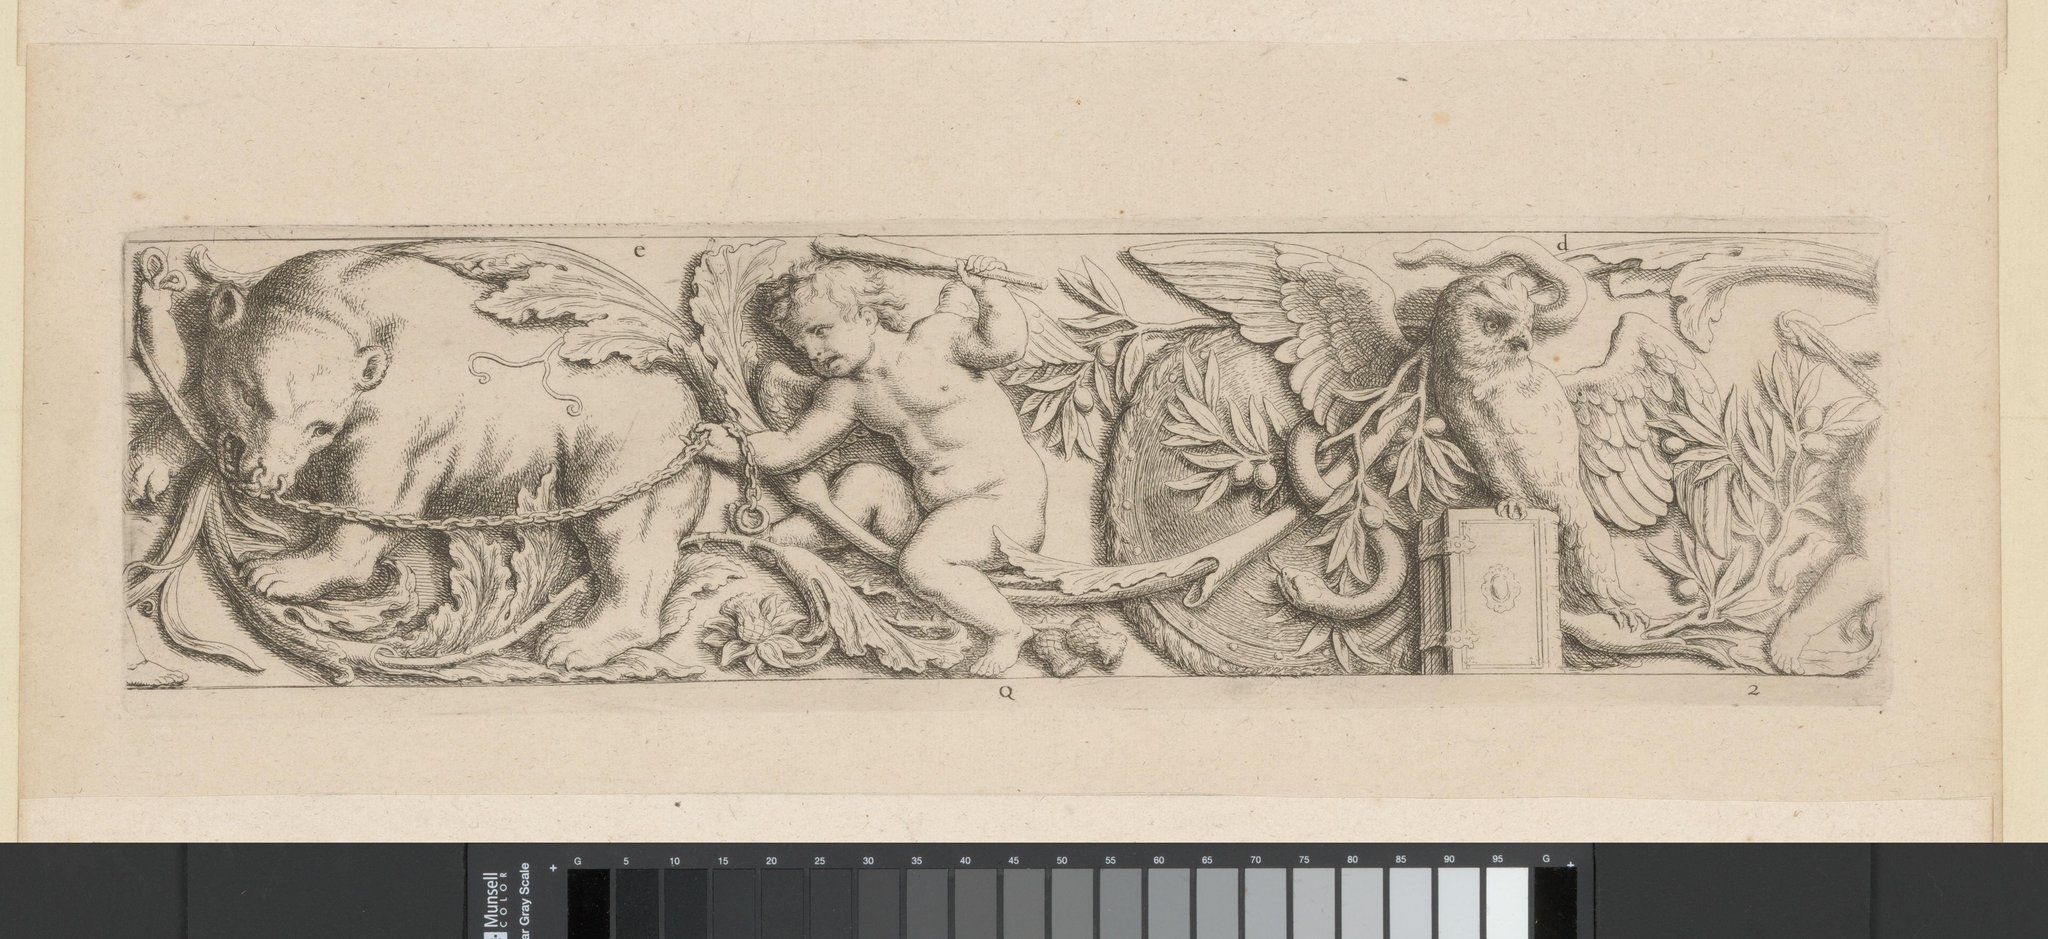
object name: print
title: Deel van fries op schouw in Vroedschapskamer van het Stadhuis op de Dam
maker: hubert quellinus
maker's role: print maker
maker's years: 1619-1687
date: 1663-1668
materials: paper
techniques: engraving, etching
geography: amsterdam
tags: beasts of prey, predatory animals: bear, townhall, owls, allegory, personification of good government, cupids: 'amores', 'amoretti', 'putti'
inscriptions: collector's mark: ‘16,84’ Lugt 1641b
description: Prent gebruikt in: Secunca pars Praecipuarum effigierum ac ornamentorum amplissime Curiae Amstelrodamensis maiori ex parte in cadido marmore effectorum per Artum Quellinium eiusdem Civitatis Statuarium / Het tweede deel Van de voornaemste Statuen ende Cieraten van 't konst-rijcke Stadt-huys van Amstelredam 'tmeeste in Marmer gemaeckt door Artus Quellinus Beelthouwer der voorseyde Stadt. Amsterdam: Artus Quellinus (I), 1663. Zie RP-P-AO-22-2-1 voor bijhorende titelpagina. Zie RP-P-AO-22-2-2 voor bijhorend register. Zie RP-P-AO-22-2A, RP-P-AO-22-2B, RP-P-AO-22-2C-1, RP-P-AO-22-2C-2, RP-P-AO-22-2C-3, RP-P-AO-22-2C-4, RP-P-AO-22-2D-1, RP-P-AO-22-2D-2, RP-P-AO-22-2D-3, RP-P-AO-22-2E-1, RP-P-AO-22-2E-2, RP-P-AO-22-2E-3, RP-P-AO-22-2E-4, RP-P-AO-22-2F-1, RP-P-AO-22-2F-2, RP-P-AO-22-2F-3, RP-P-AO-22-2G, RP-P-AO-22-2H, RP-P-AO-22-2I, RP-P-AO-22-2K, RP-P-AO-22-2L, RP-P-AO-22-2M, RP-P-AO-22-2N, RP-P-AO-22-2O-1, RP-P-AO-22-2O-2, RP-P-AO-22-2O-3, RP-P-AO-22-2O-4, RP-P-AO-22-2O-5, RP-P-AO-22-2O-6, RP-P-AO-22-2O-7, RP-P-AO-22-2P-1, RP-P-AO-22-2P-2, RP-P-AO-22-2Q-1, RP-P-AO-22-2Q-3, RP-P-AO-22-2R-1, RP-P-AO-22-2R-2, RP-P-AO-22-2R-3, RP-P-AO-22-2S, RP-P-AO-22-2T-1, RP-P-AO-22-2T-2, RP-P-AO-22-2T-3, RP-P-AO-22-2T-4, RP-P-AO-22-2V-1, RP-P-AO-22-2V-2, RP-P-AO-22-2W-1, RP-P-AO-22-2W-2, RP-P-AO-22-2X-1, RP-P-AO-22-2X-2 en RP-P-AO-22-2X-3 voor andere prenten uit deze publicatie. Zelfde staat van prent ook gebruikt in: Secunca pars Praecipuarum effigierum ac ornamentorum amplissime Curiae Amstelrodamensis maiori ex parte in cadido marmore effectorum per Artum Quellinium eiusdem Civitatis Statuarium / Het tweede deel Van de voornaemste Statuen ende Cieraten van 't konst-rijcke Stadt-huys van Amstelredam 'tmeeste in Marmer gemaeckt door Artus Quellinus Beelthouwer der voorseyde Stadt. Amsterdam: Frederik de Wit, 1668. Latere staat van prent ook gebruikt in: Architecture peinture et sculpture de la Maison de Ville d'Amsterdam, representee en CIX. figures en taille-douce (…). Amsterdam: David Mortier, 1719. En in: Architecture peinture et sculpture de la Maison de Ville d'Amsterdam, representee en CIX. figures en taille-douce (…). Amsterdam: Gerard Valck, 1719. En in: Bouw schilder en beeldhouwkonst, van het Stadhuis te Amsteldam, vertoont in CIX figuuren (…). Amsterdam: Covens & Mortier & Covens Jr., s.a. (1774-1783).